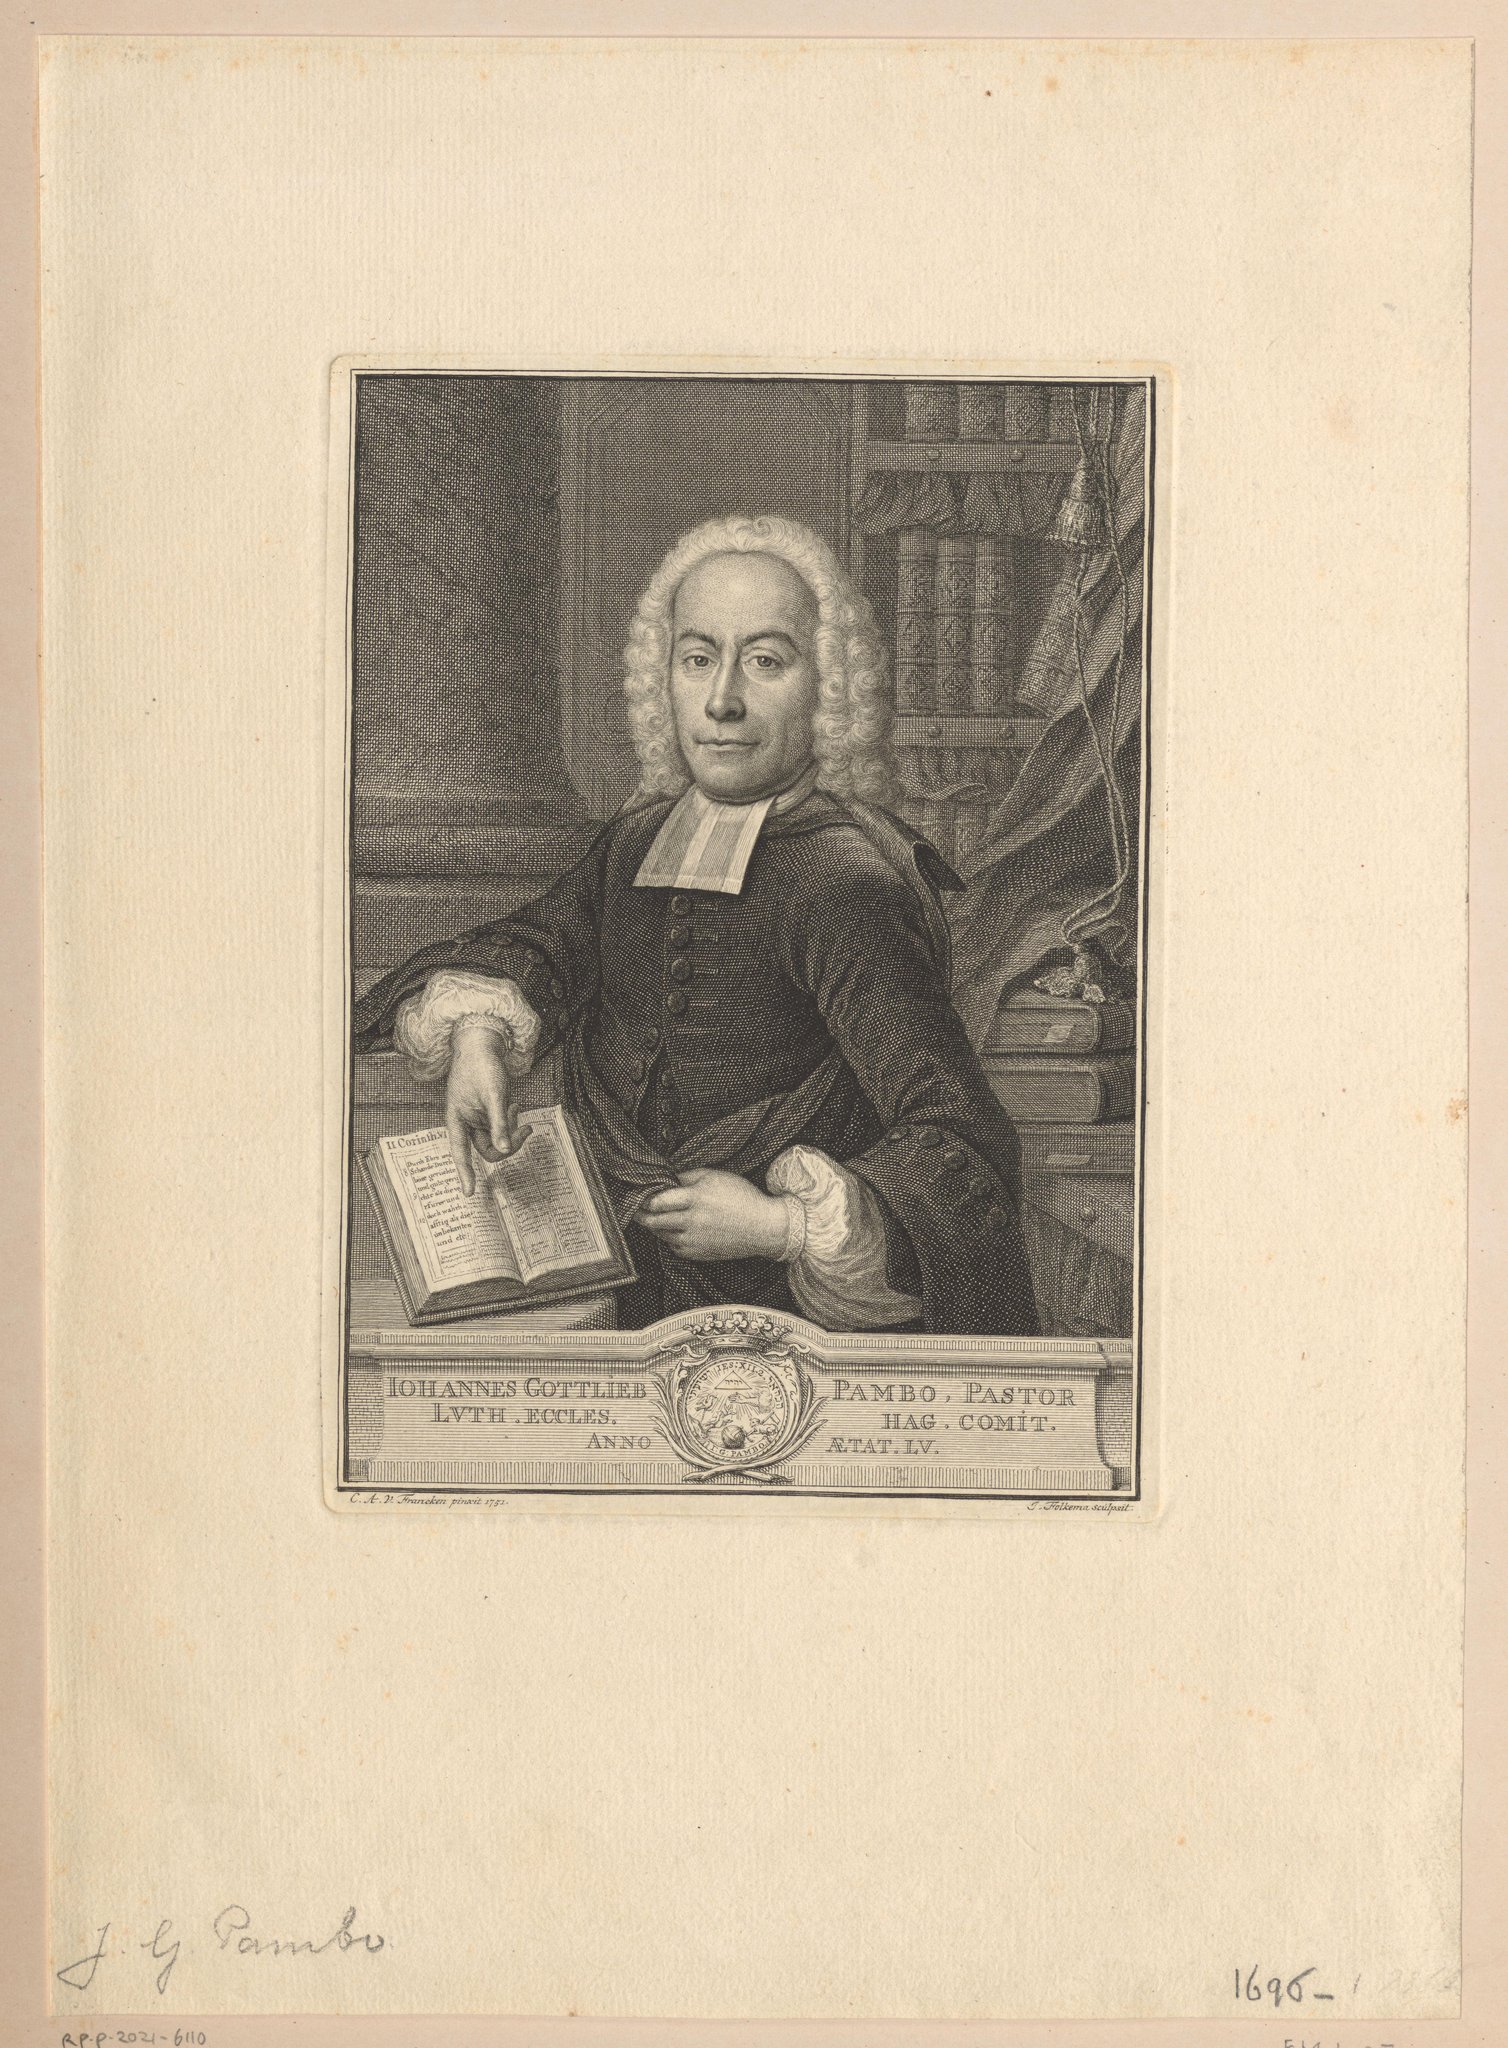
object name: print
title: Portret van Johann Gotlieb Pambo op 55-jarige leeftijd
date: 1751-1767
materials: paper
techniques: engraving, etching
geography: netherlands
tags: berlin, the hague, adult man, historical persons, book - mm - book open, study; 'studiolo'; library, functionaries and dignitaries ~ protestant churches